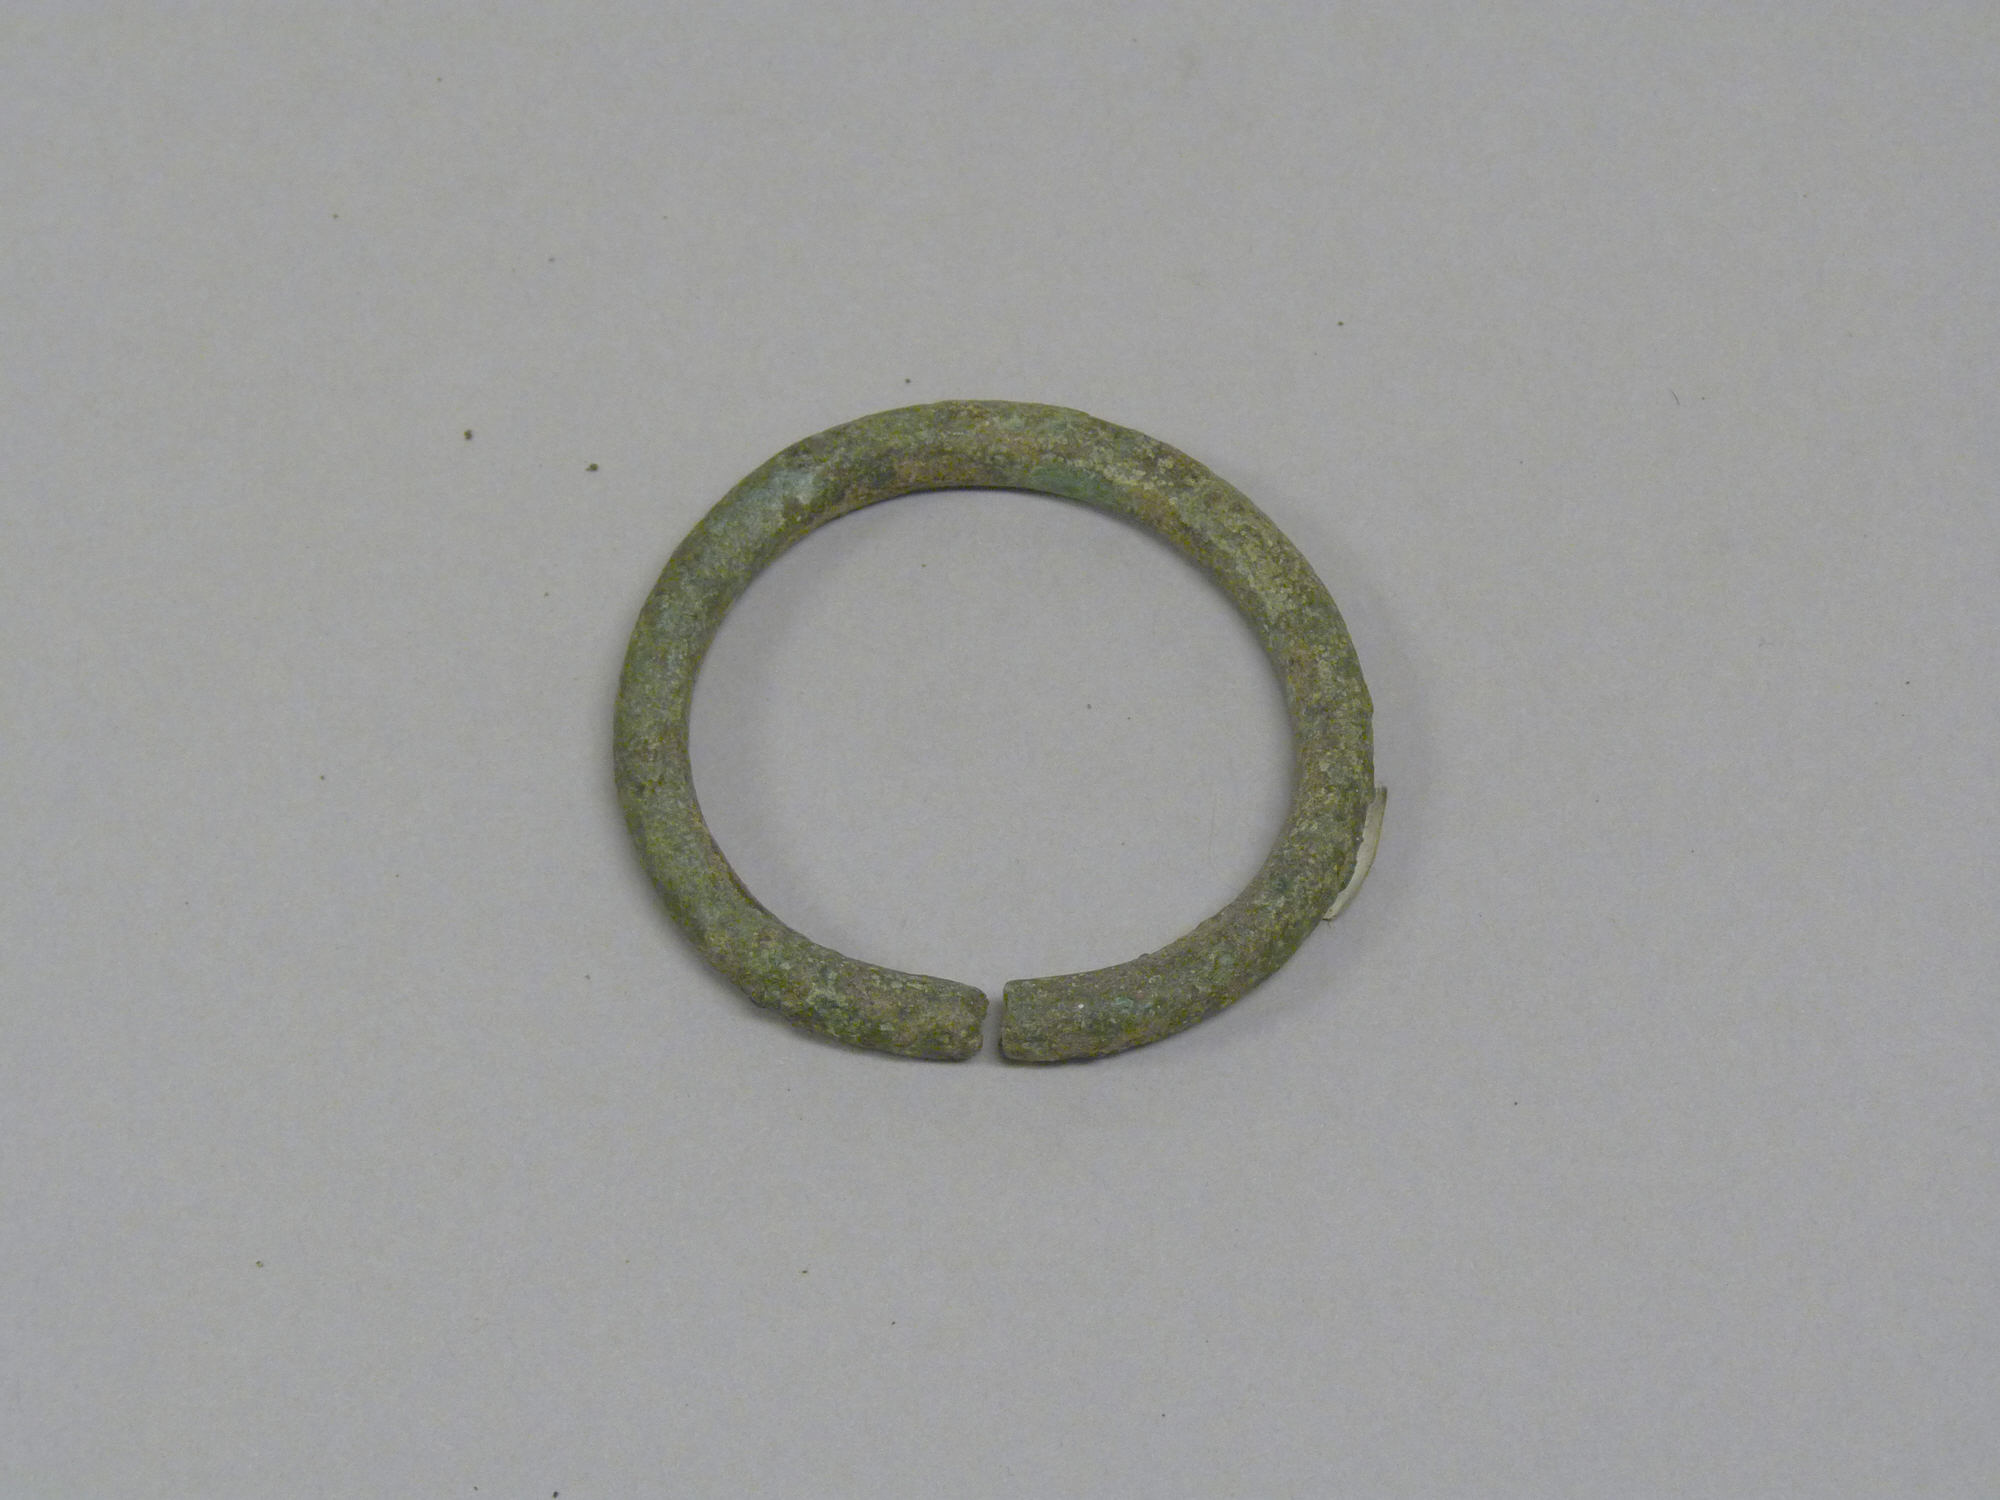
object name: bangle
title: One from a Pair of Solid Undecorated Bangles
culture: thai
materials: bronze